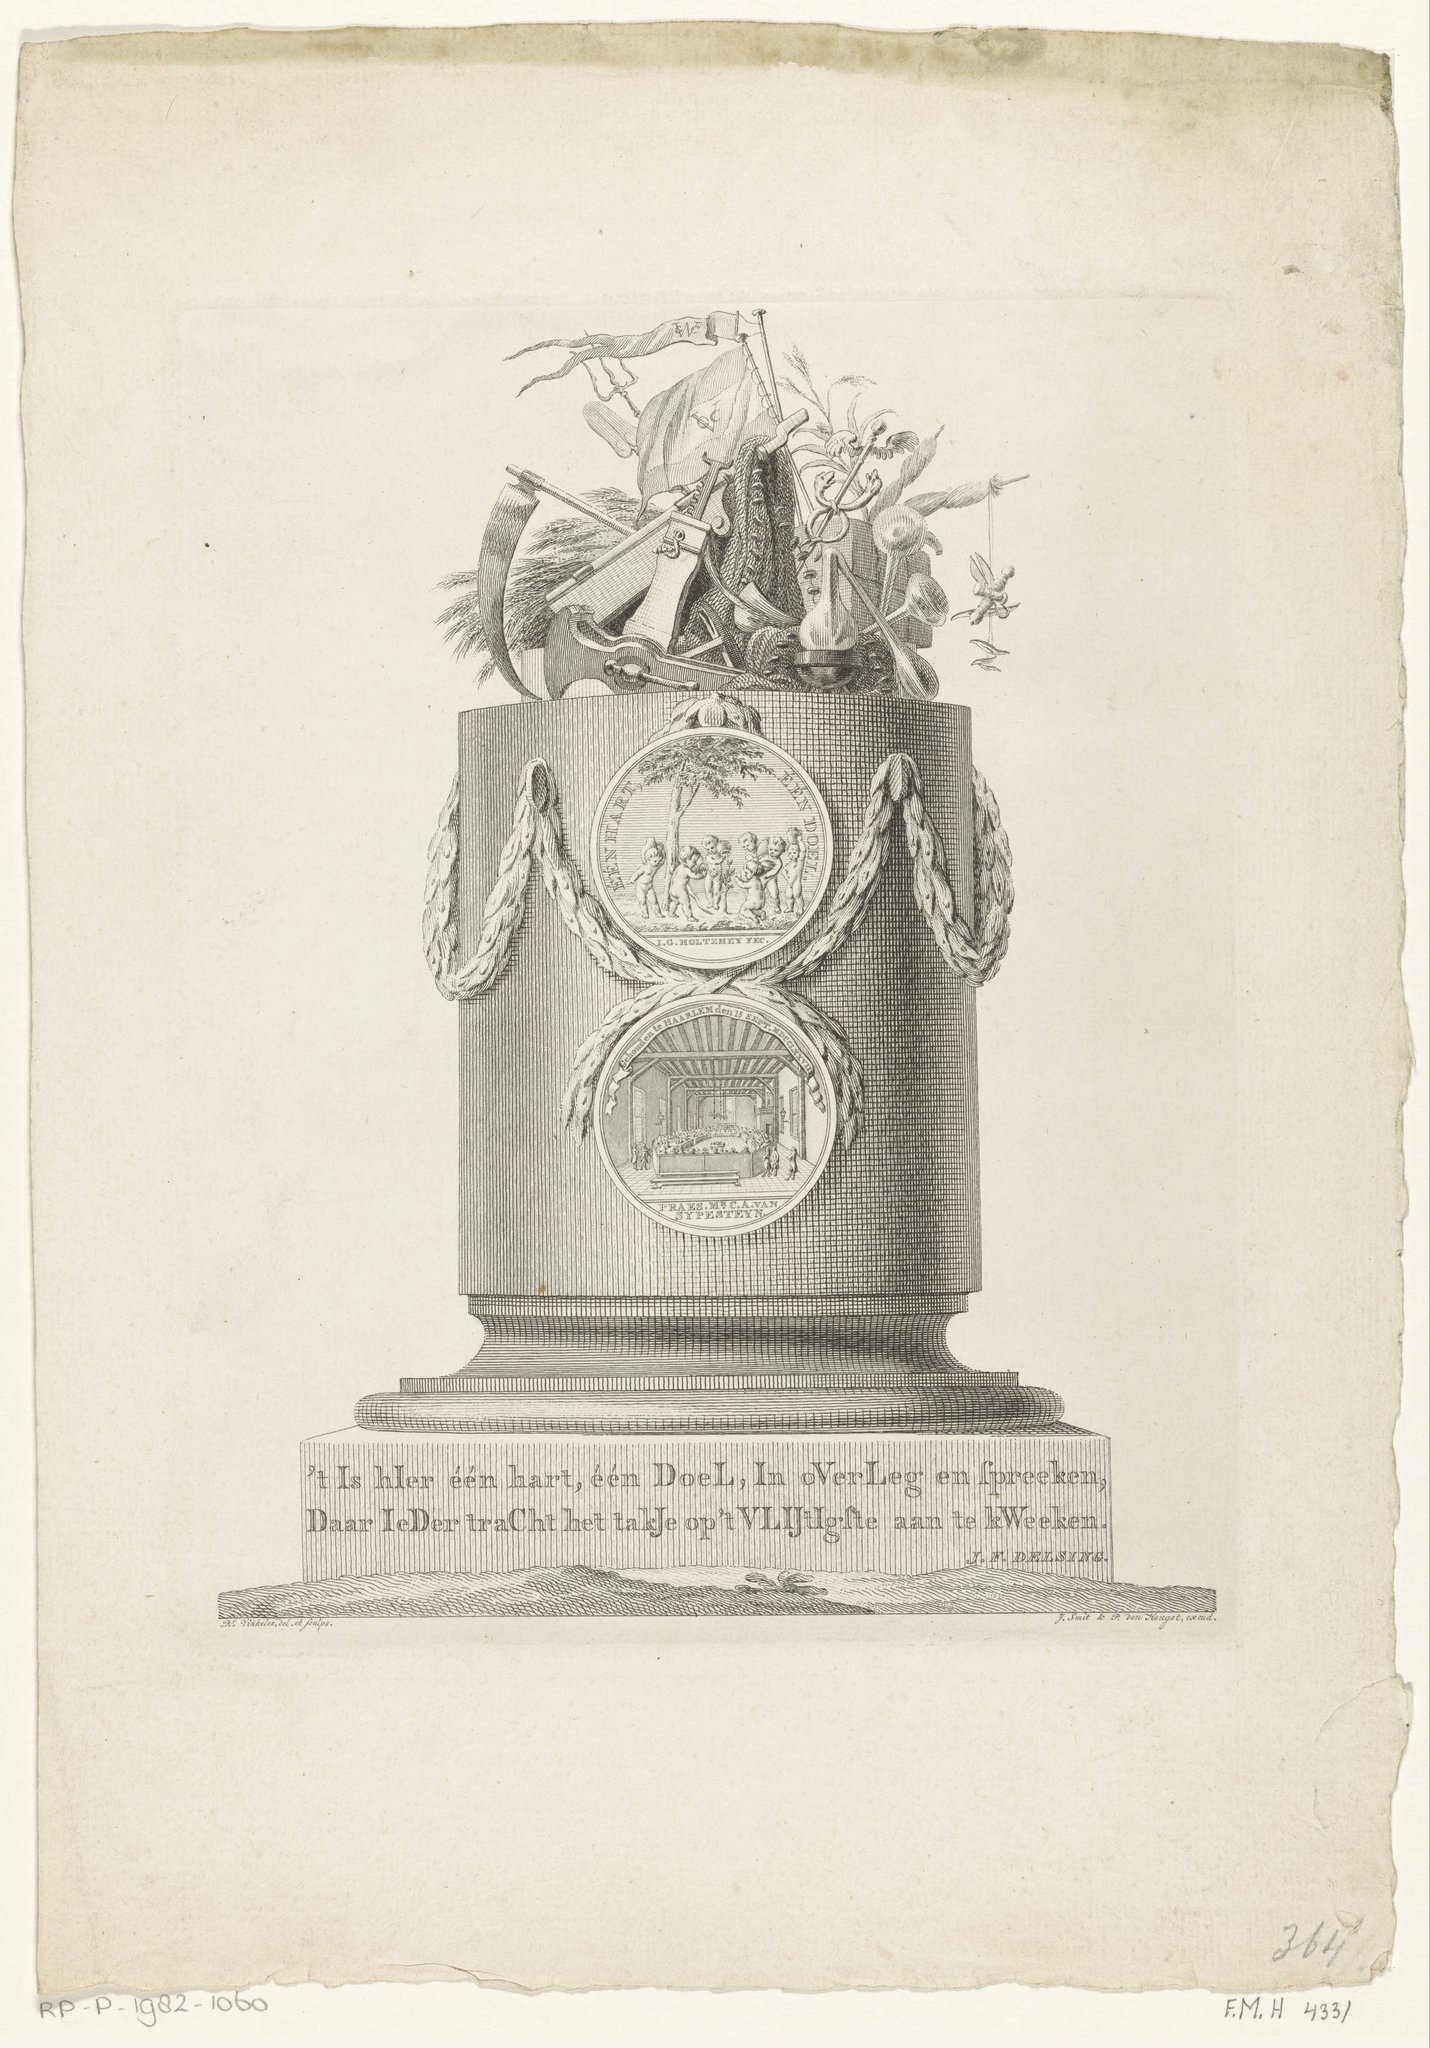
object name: print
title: Tijdvers op de algemene vergadering van de Oeconomische tak van de Maatschappij der Wetenschappen te Haarlem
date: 1778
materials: paper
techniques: engraving, etching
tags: meeting, assembly, medal (considered as a piece of sculpture, regardless of its specific function)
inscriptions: collector's mark: Lugt 2760, collector's mark: Lugt 2228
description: Zuil met voetstuk waarop een tijdvers op de algemene vergadering van de nieuwe Oeconomische tak van de Maatschappij der Wetenschappen te Haarlem, gehouden op 15 september 1778 in de zaal van het Diaconiehuis te Haarlem. Op de voorzijde van de zuil de penning geslagen ter gelegenheid van deze bijeenkomst, bovenop attributen van de beoefende wetenschappen.